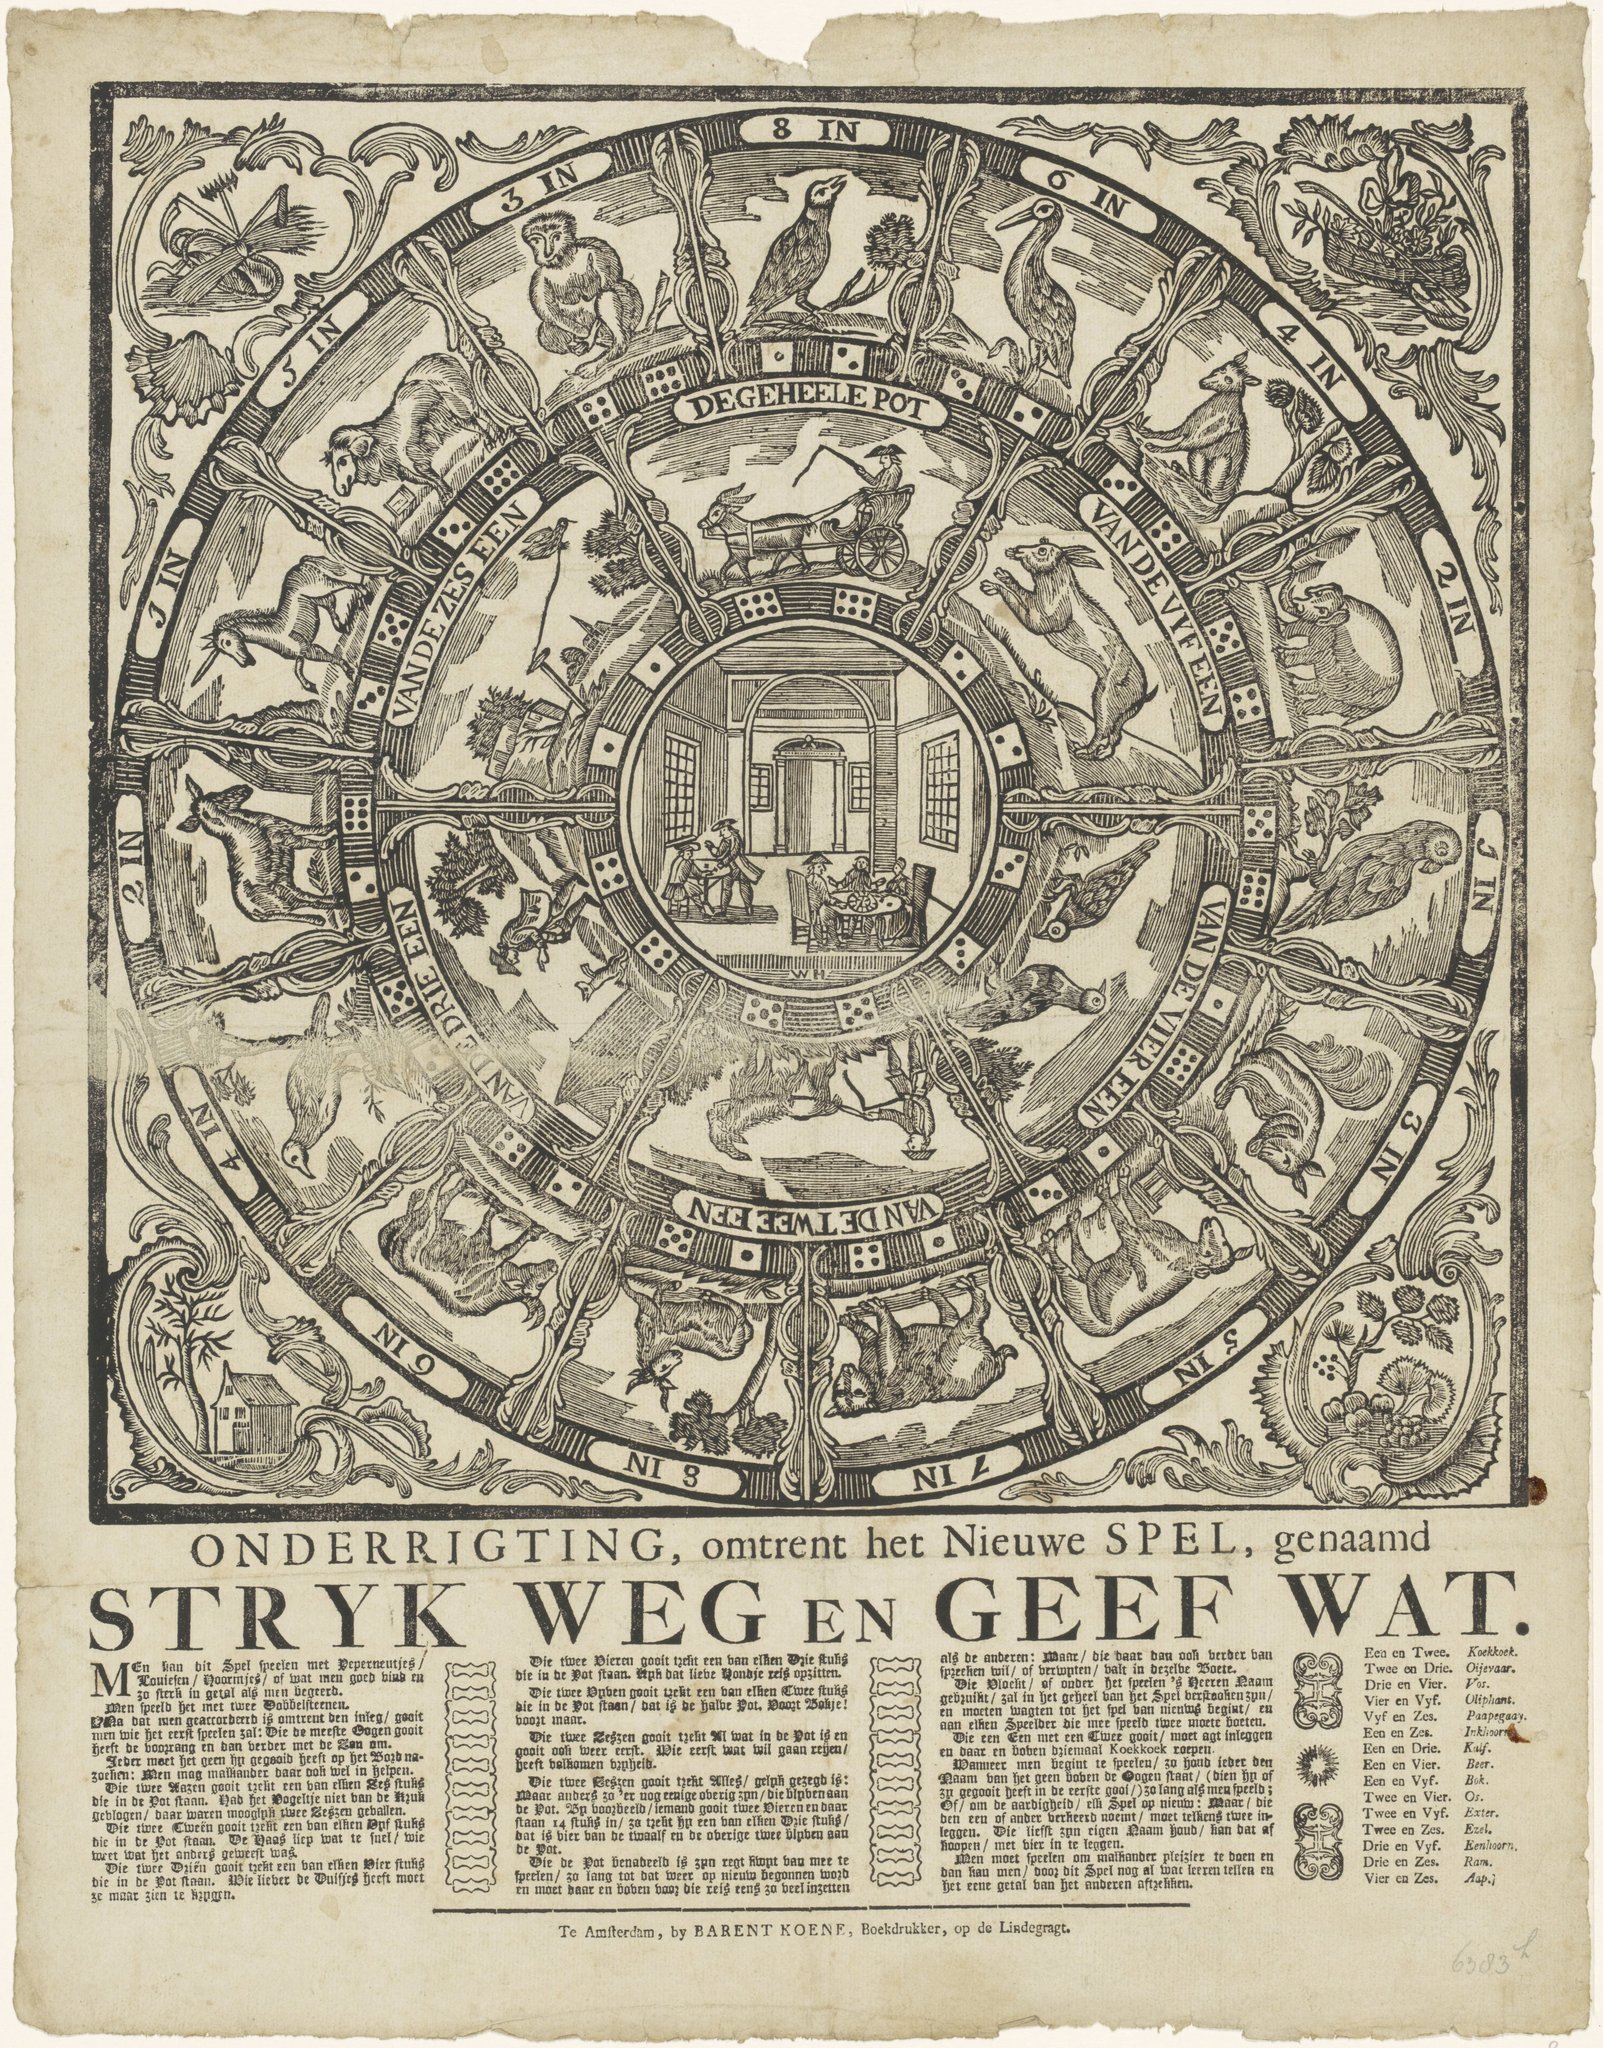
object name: print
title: Bordspel genaamd 'Strijk weg en Geef wat', ca. 1760-1780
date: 1759-1781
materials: paper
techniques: letterpress printing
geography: netherlands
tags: board-games of chance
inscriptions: collector's mark: Lugt 2228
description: Bordspel genaamd 'Strijk weg en Geef wat'en bestaande uit twee concentrische cirkels met vakjes met dieren. Onderaan de spelregels. Onderdeel van een groep van kinder- en gezelschapsspelen gedrukt in de periode ca. 1750-1850.